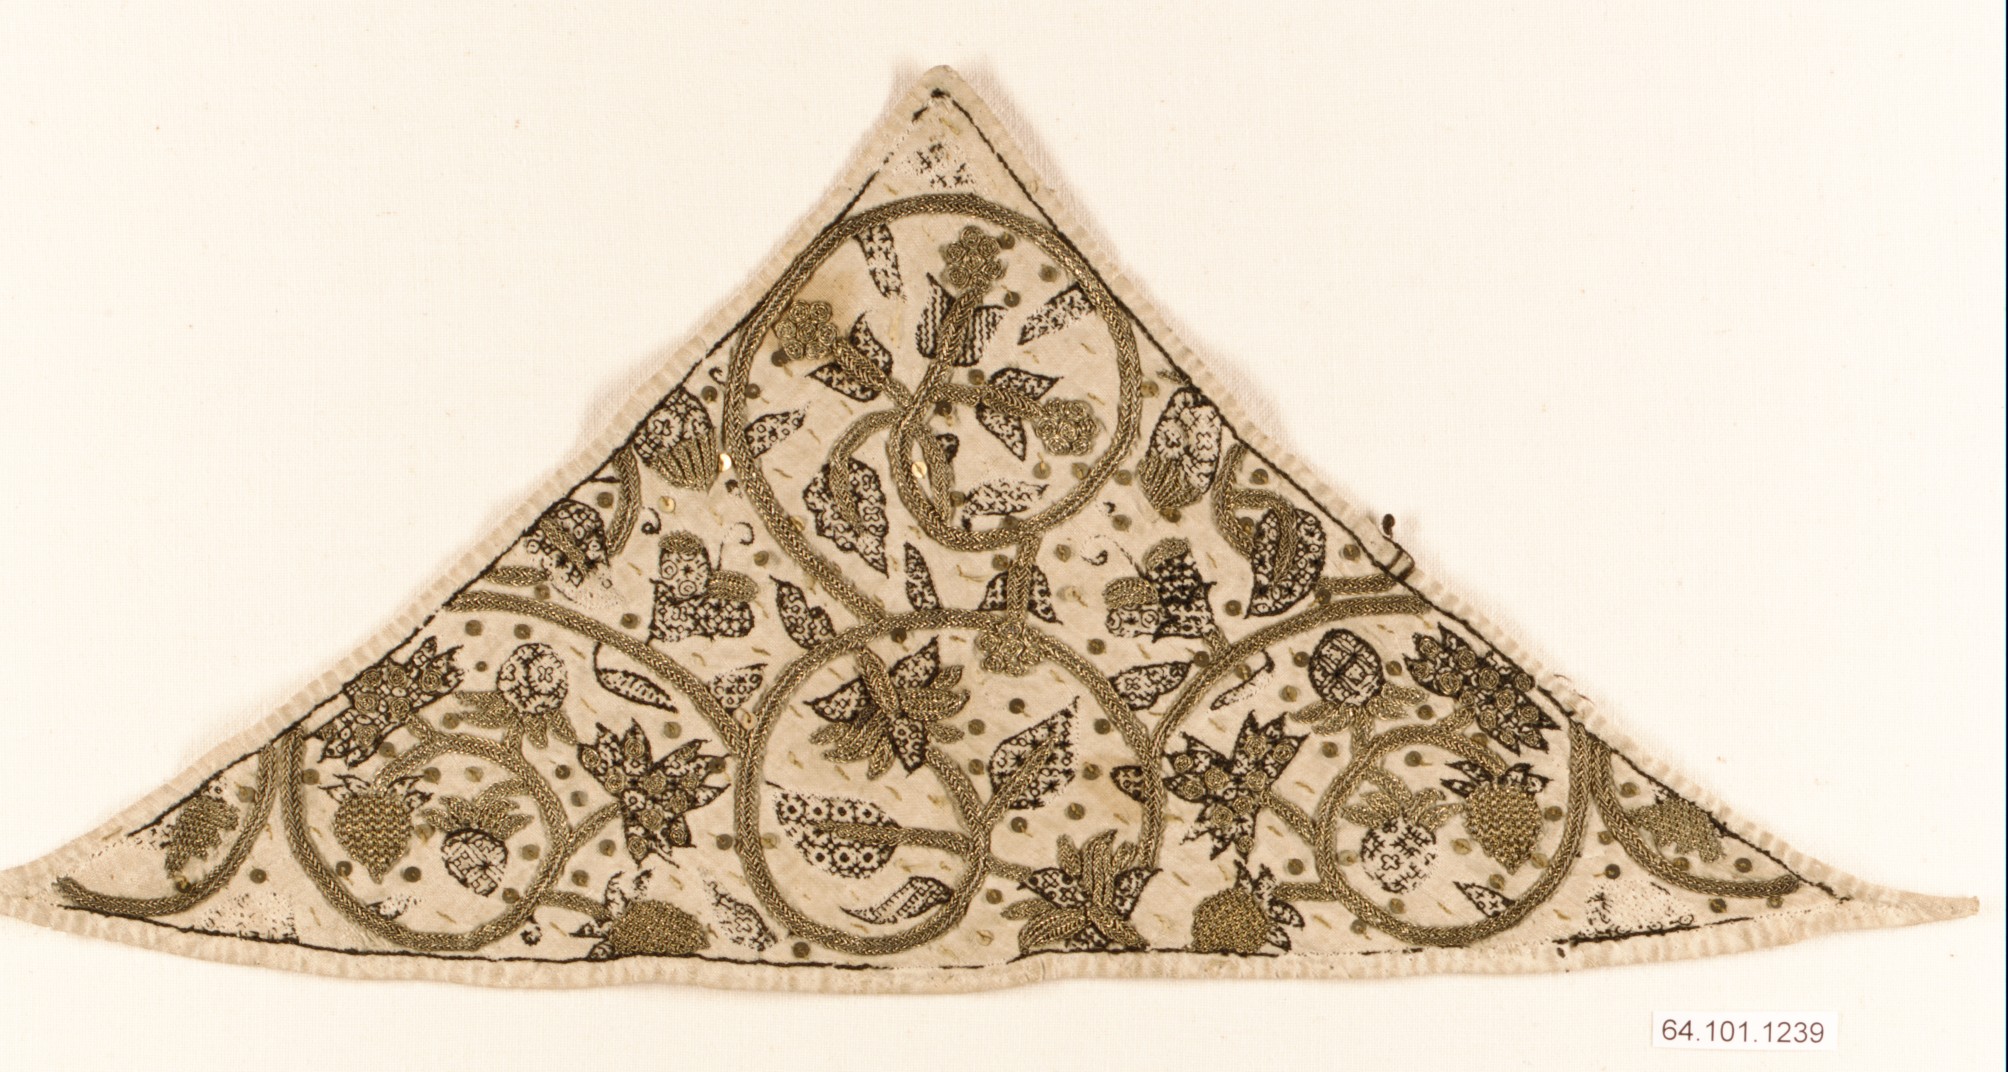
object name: forehead cloth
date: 1576-1600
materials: linen, metal thread, silk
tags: flowers